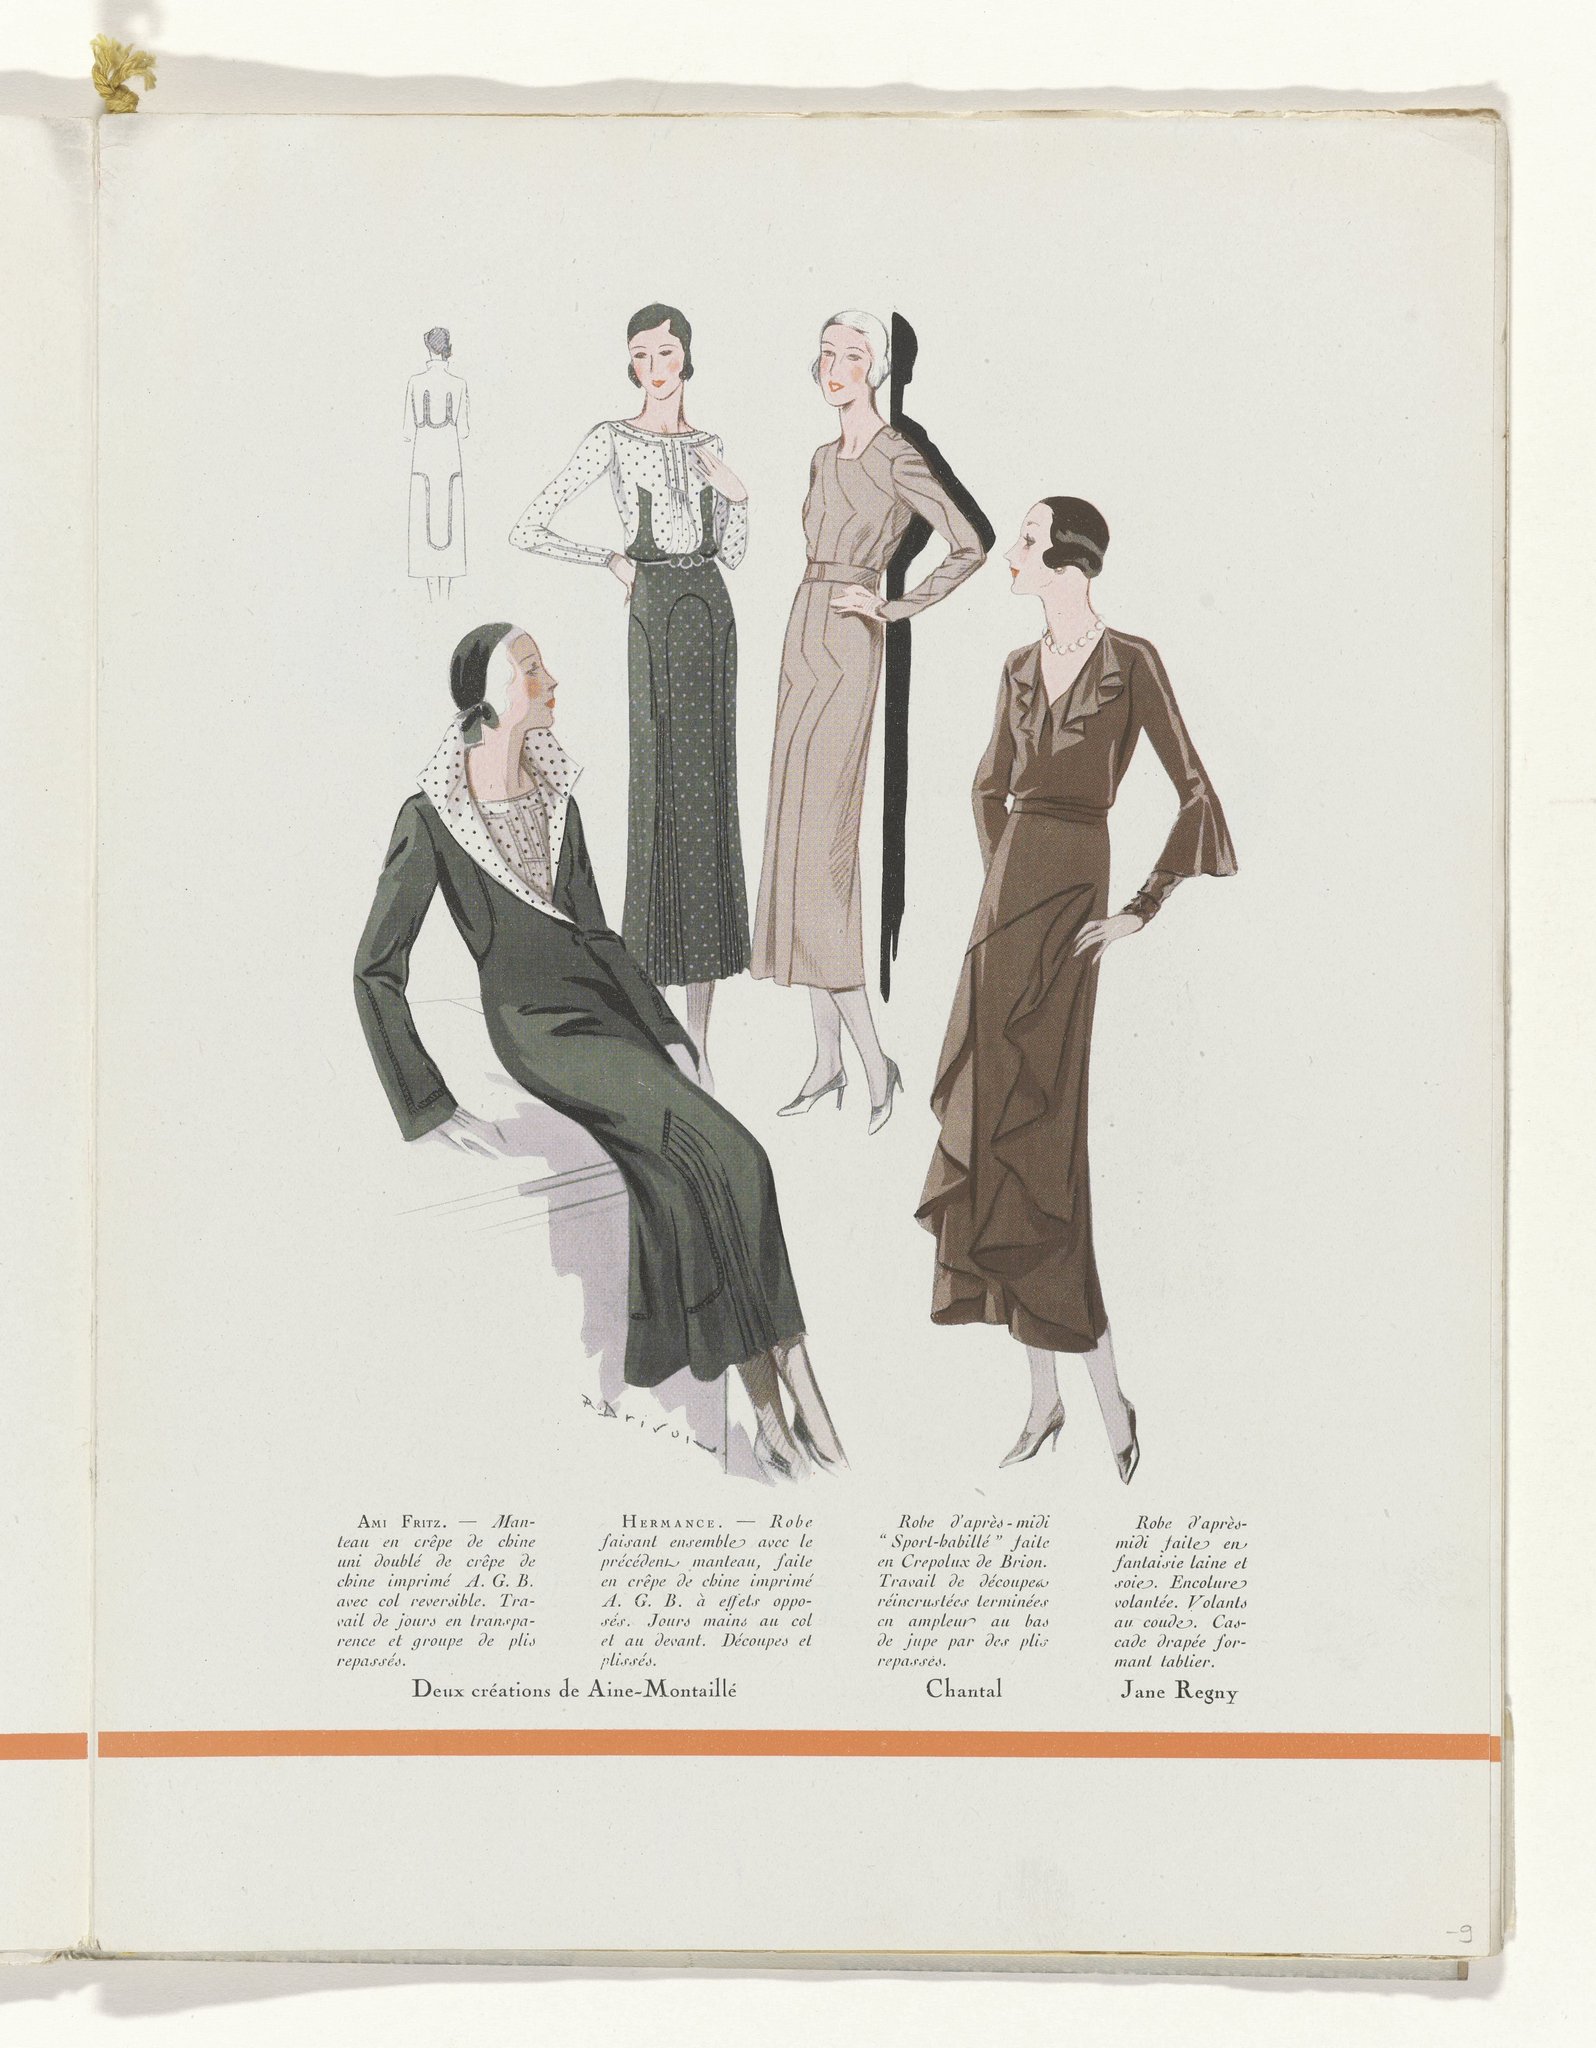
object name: fashion print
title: Art - Goût - Beauté, Feuillets de l' élégance féminine, Mai 1931, No. 129, 11e Année, p. 9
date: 1931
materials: paper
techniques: printing, photography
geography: paris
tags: dress, gown: day dress (+ women's clothes), dress, gown (afternoon dress) (+ women's clothes), coat (+ women's clothes), fashion plates, clothes, costume (+ women's clothes), necklace (+ women's clothes)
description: Links: ensemble, bestaande uit een mantel en jurk van bedrukte 'crêpe de chine A.G.B.' van Aine-Montaillé. Midden: middagjapon "Sport- habillé" van 'Crepolux', stof van Paul Brion en ontwerp van Chantal. Rechts: middagjapon van 'fantaisie laine' (wol) en zijde, van Jane Regny. Pagina uit het modetijdschrift Art-Goût-Beauté (1920-1933).